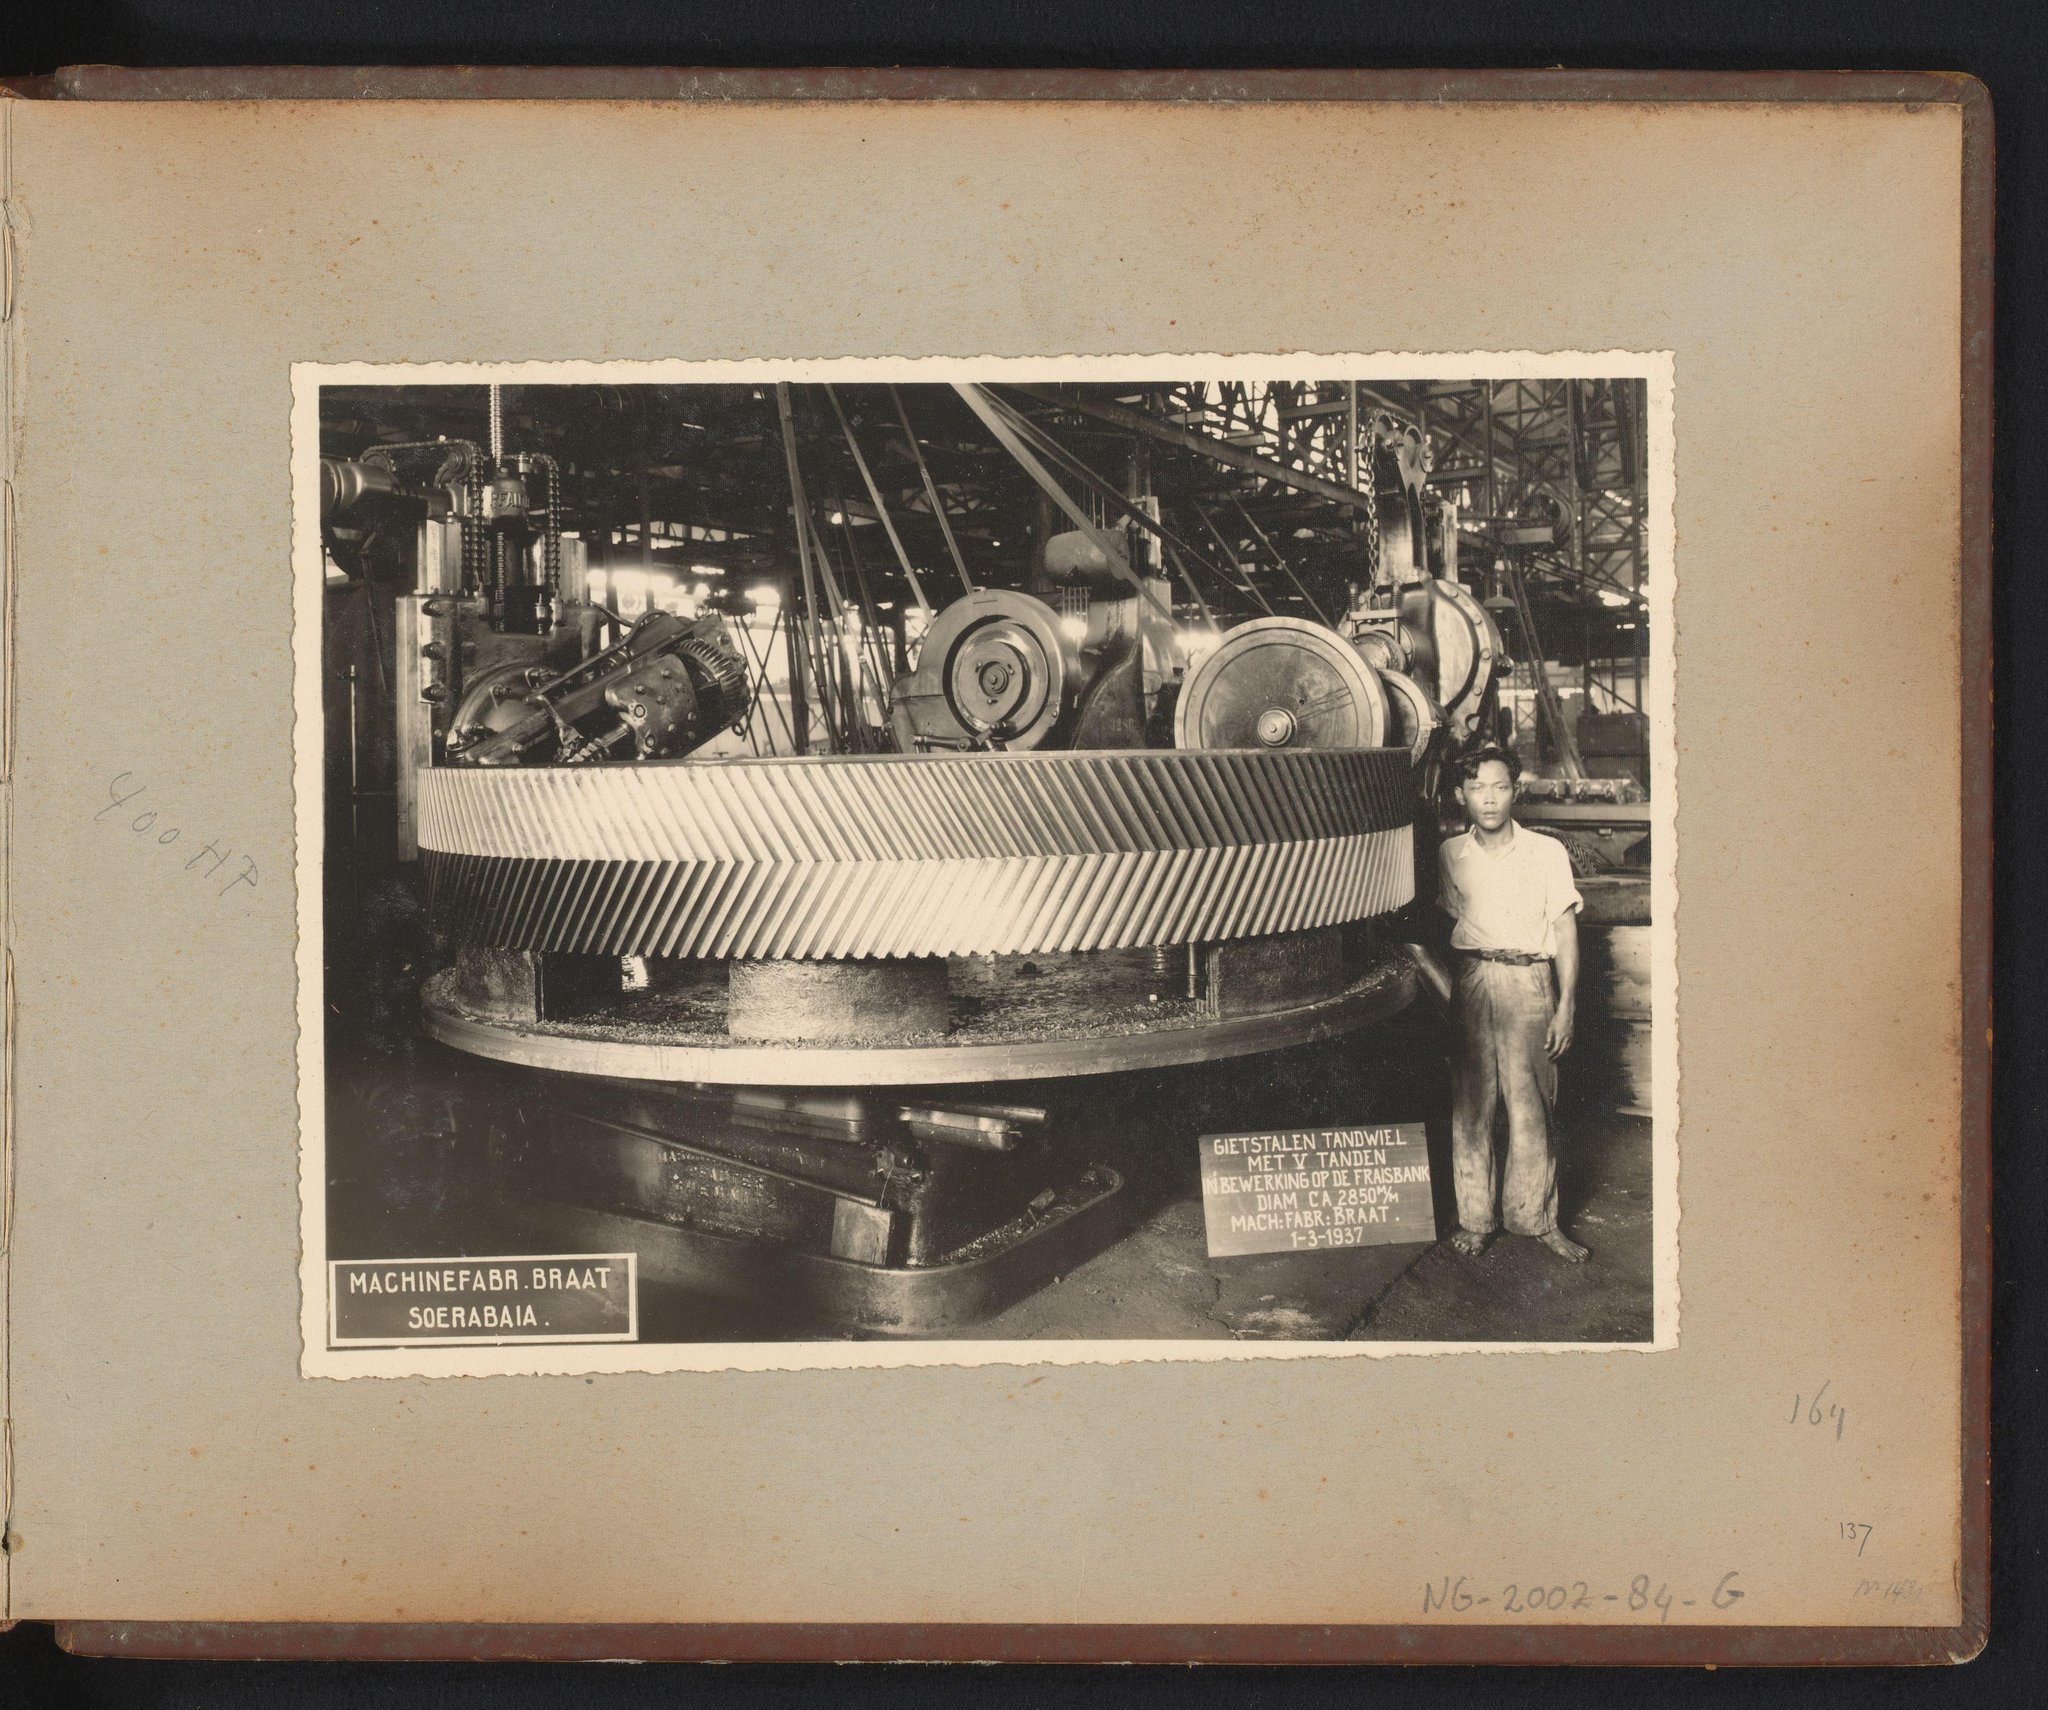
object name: album leaf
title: Tandwiel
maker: Anonymous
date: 1937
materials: cardboard, photographic support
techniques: gelatin silver print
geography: surabaya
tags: parts of machines, java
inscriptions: date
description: Albumblad met een foto van een gietstalen tandwiel in bewerking op de freesbank in 1937 en bestemd voor de Suikerfabriek Gempolkerep. Onderdeel van een fotoalbum met foto's van machines en constructies van de N.V. Machinefabriek Braat te Soerabaja, Soekaboemi en Tegal uit de periode 1931-1937.